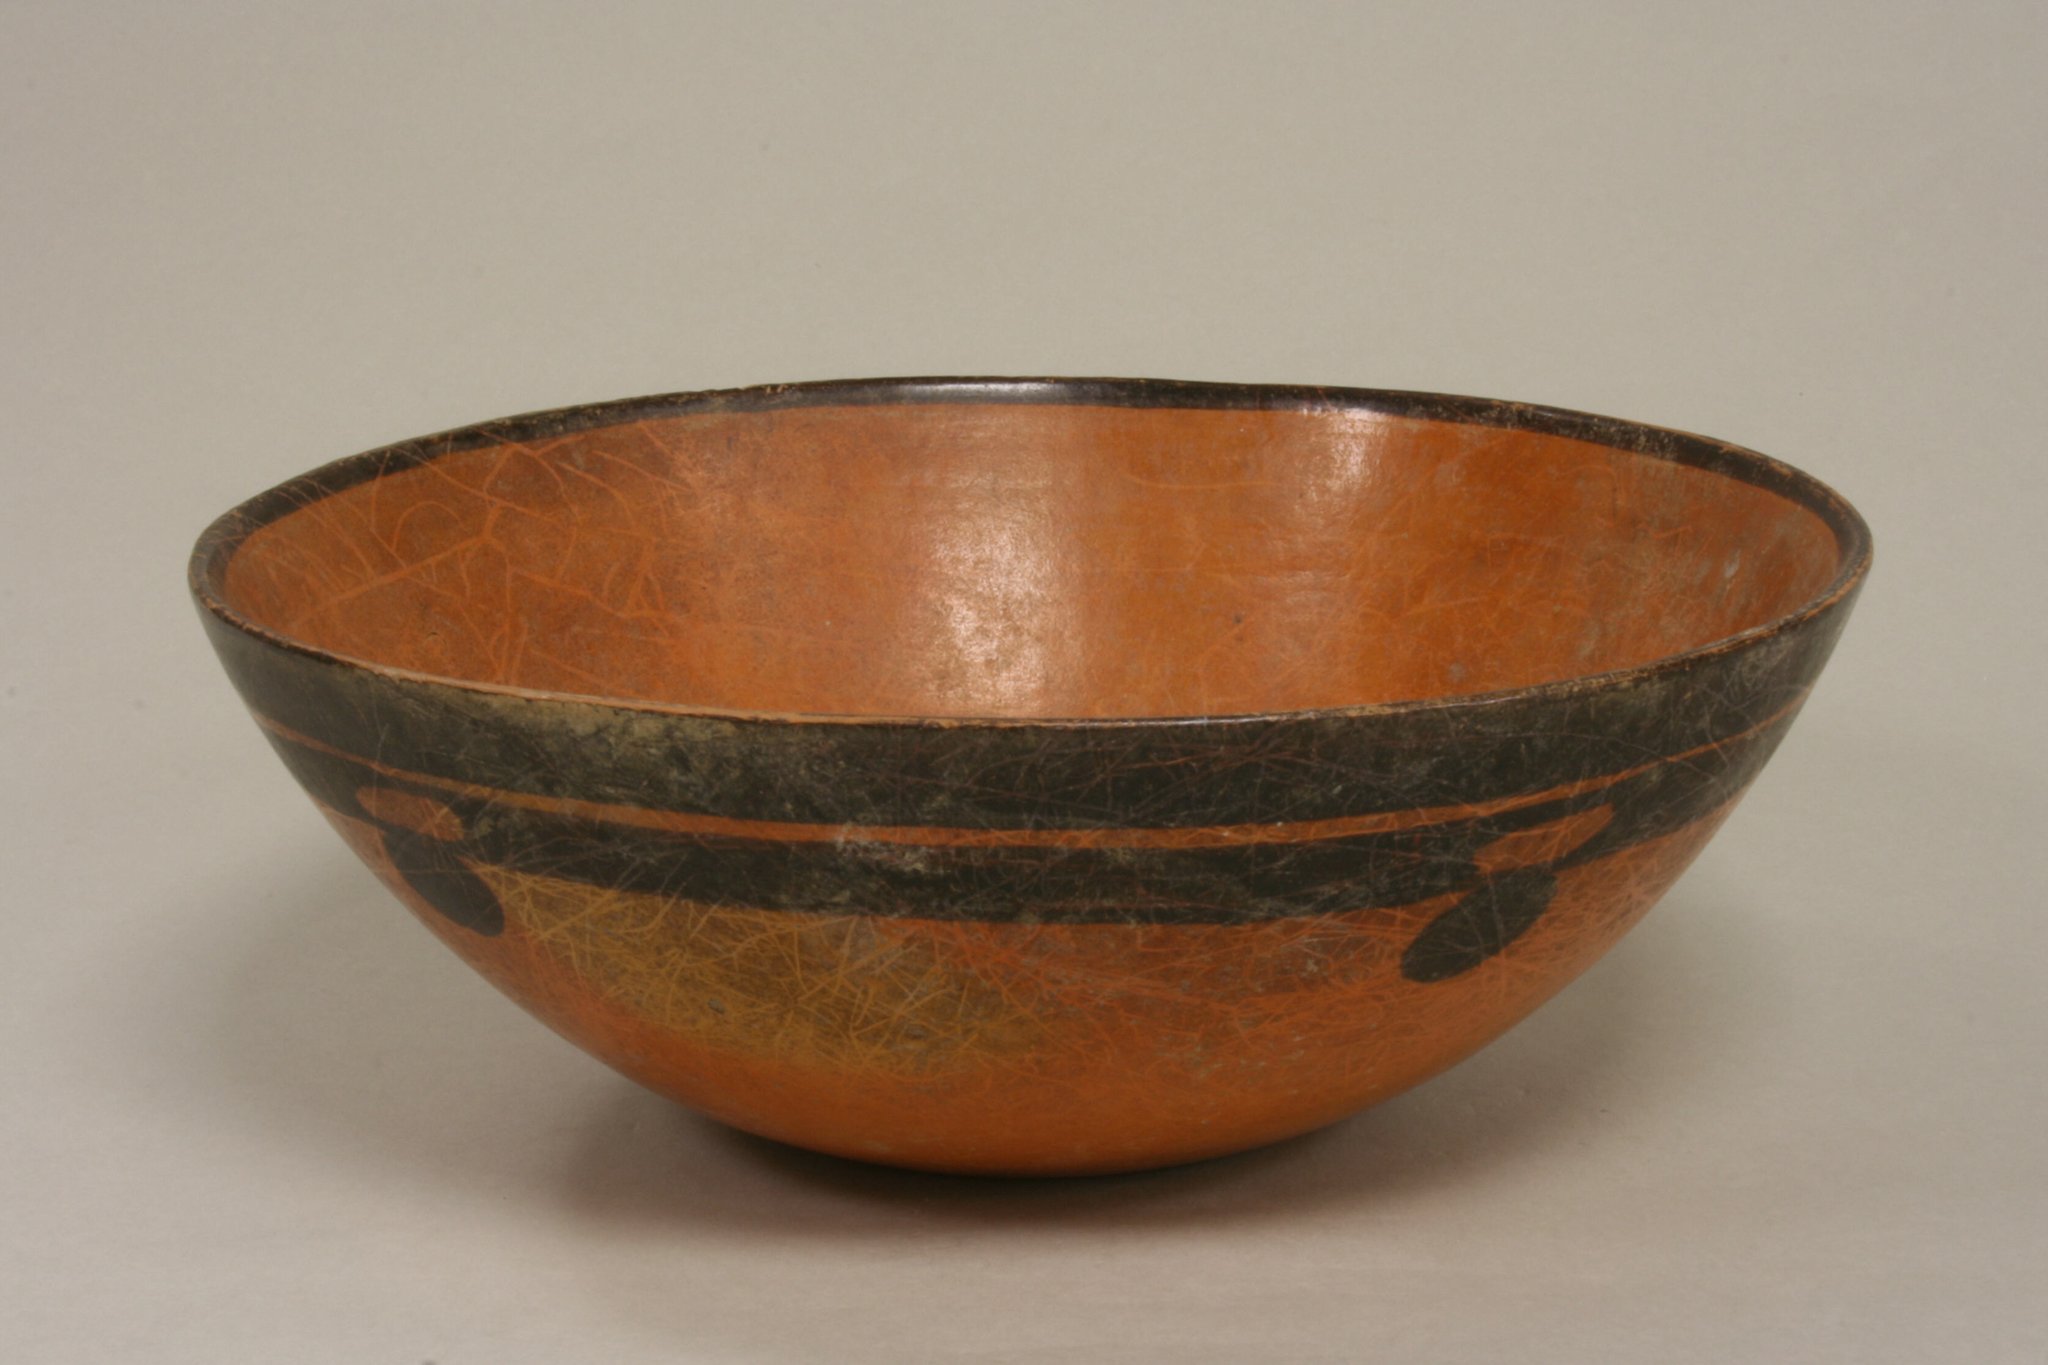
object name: bowl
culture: maya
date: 701-800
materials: ceramic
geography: guatemala or mexico